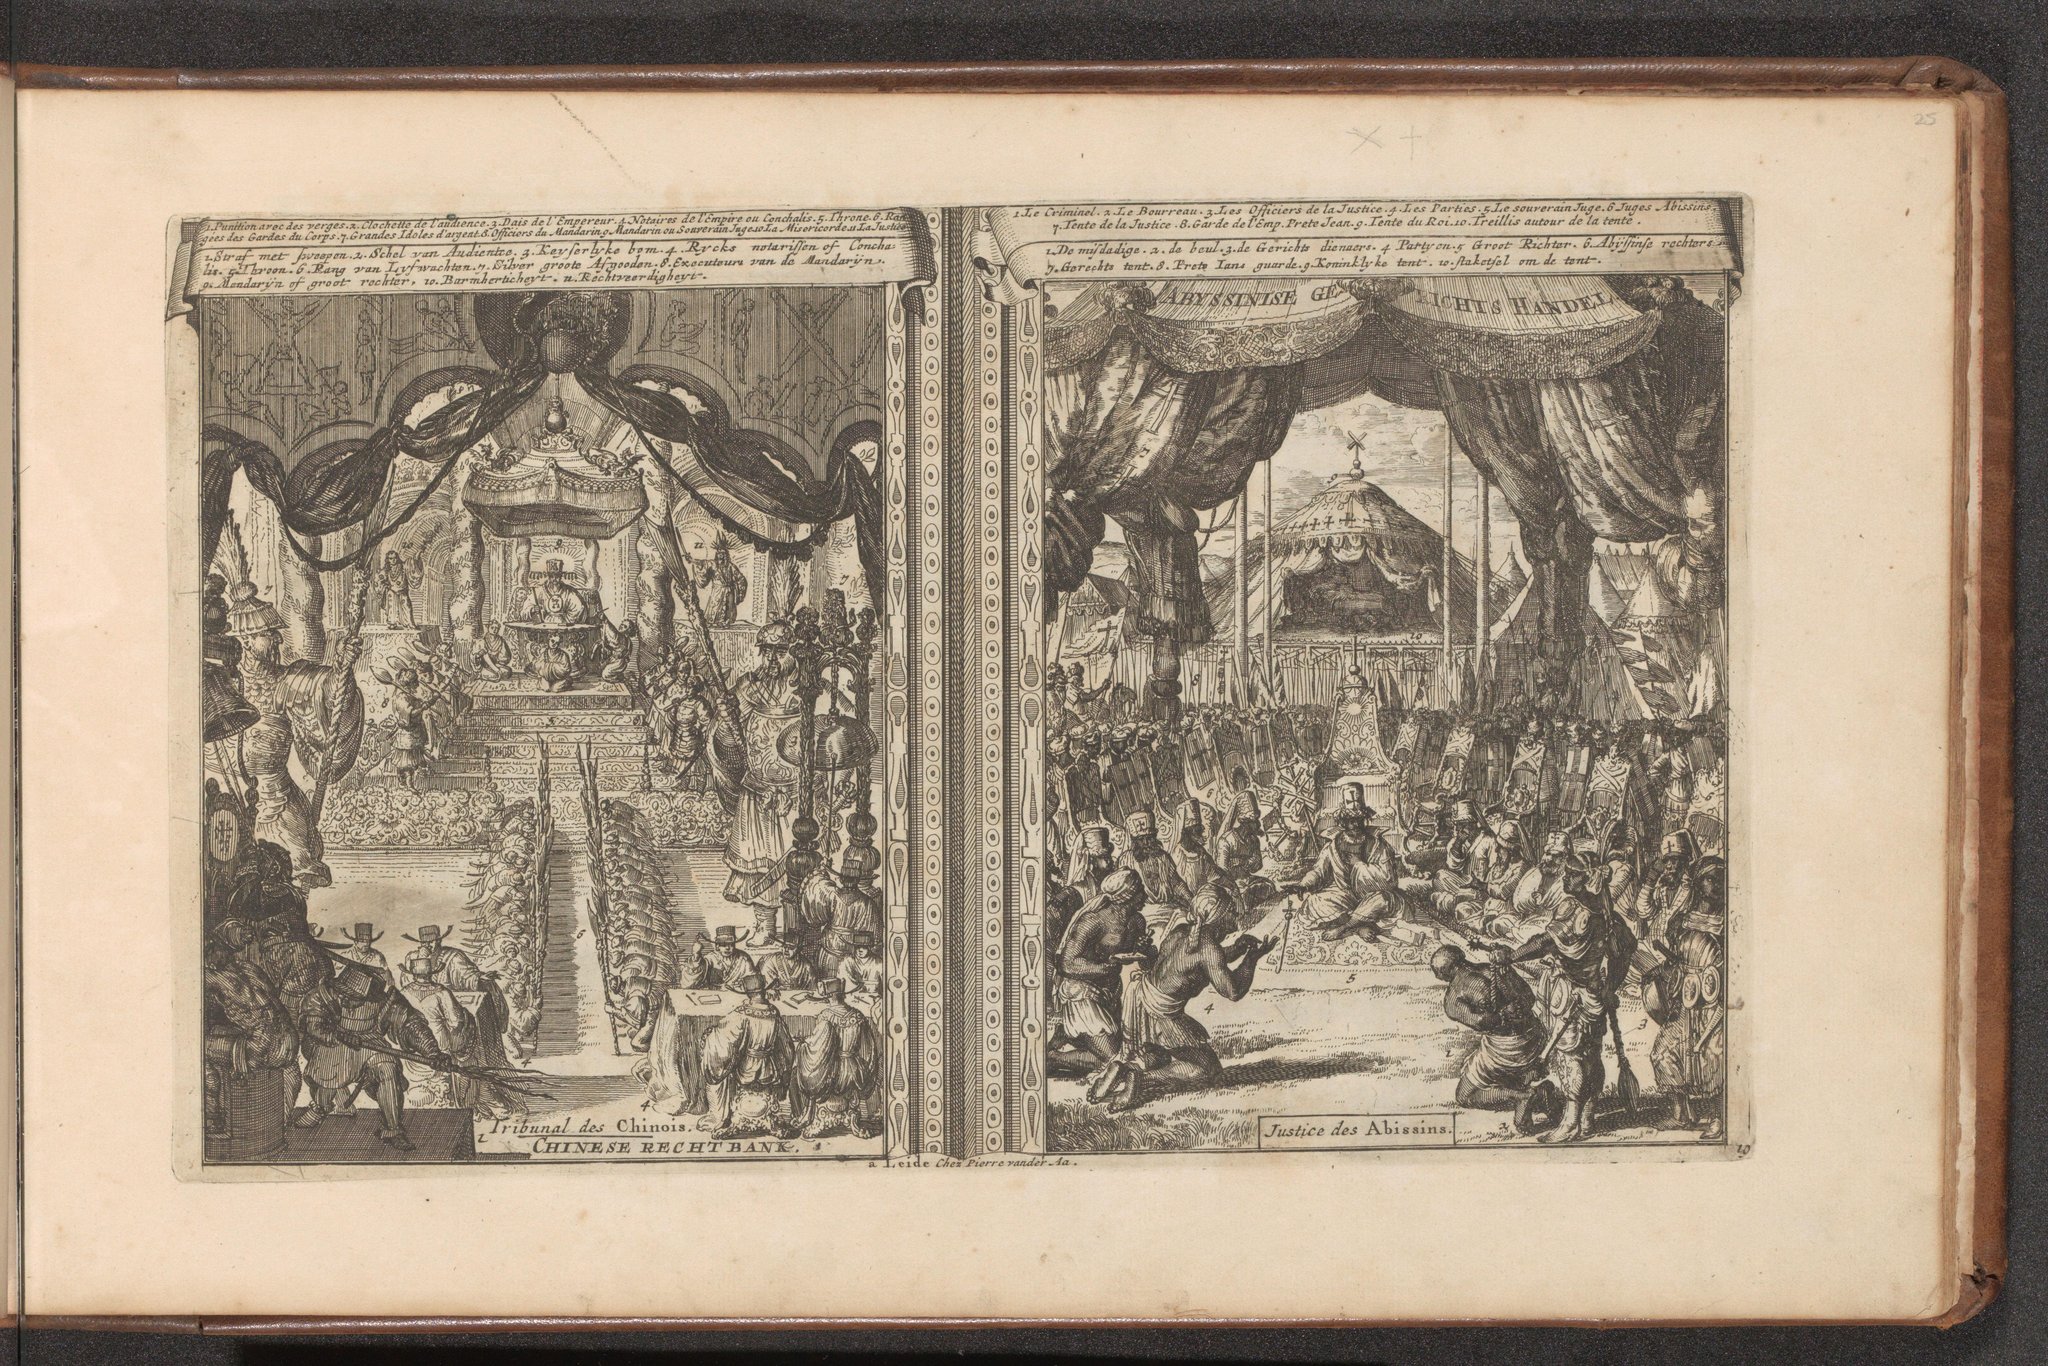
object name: album leaf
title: Rechtbank in China en Abbesinië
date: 1682-1733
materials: paper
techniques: etching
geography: leiden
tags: chinese, africans (with name), administration of justice, trial, china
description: Voorstelling in twee delen. Links een rechtbank in China. De rechter zit op een troon onder een baldakijn geflankeerd door de Barmhartigheid en de Gerechtigheid. Op de voorgrond wordt iemand gestraft met een zweep en zitten notarissen aan twee tafels. Op de rechter voorstelling de rechtbank in Abbesinië (Ethiopië). Een misdadiger wordt daar voorgeleid aan een rechter, zittend op een kleed en omringd door verschillende partijen. Op de achtergrond de koninklijke tent. Met een legenda in het Nederlands en het Frans. De prent maakt deel uit van een album.